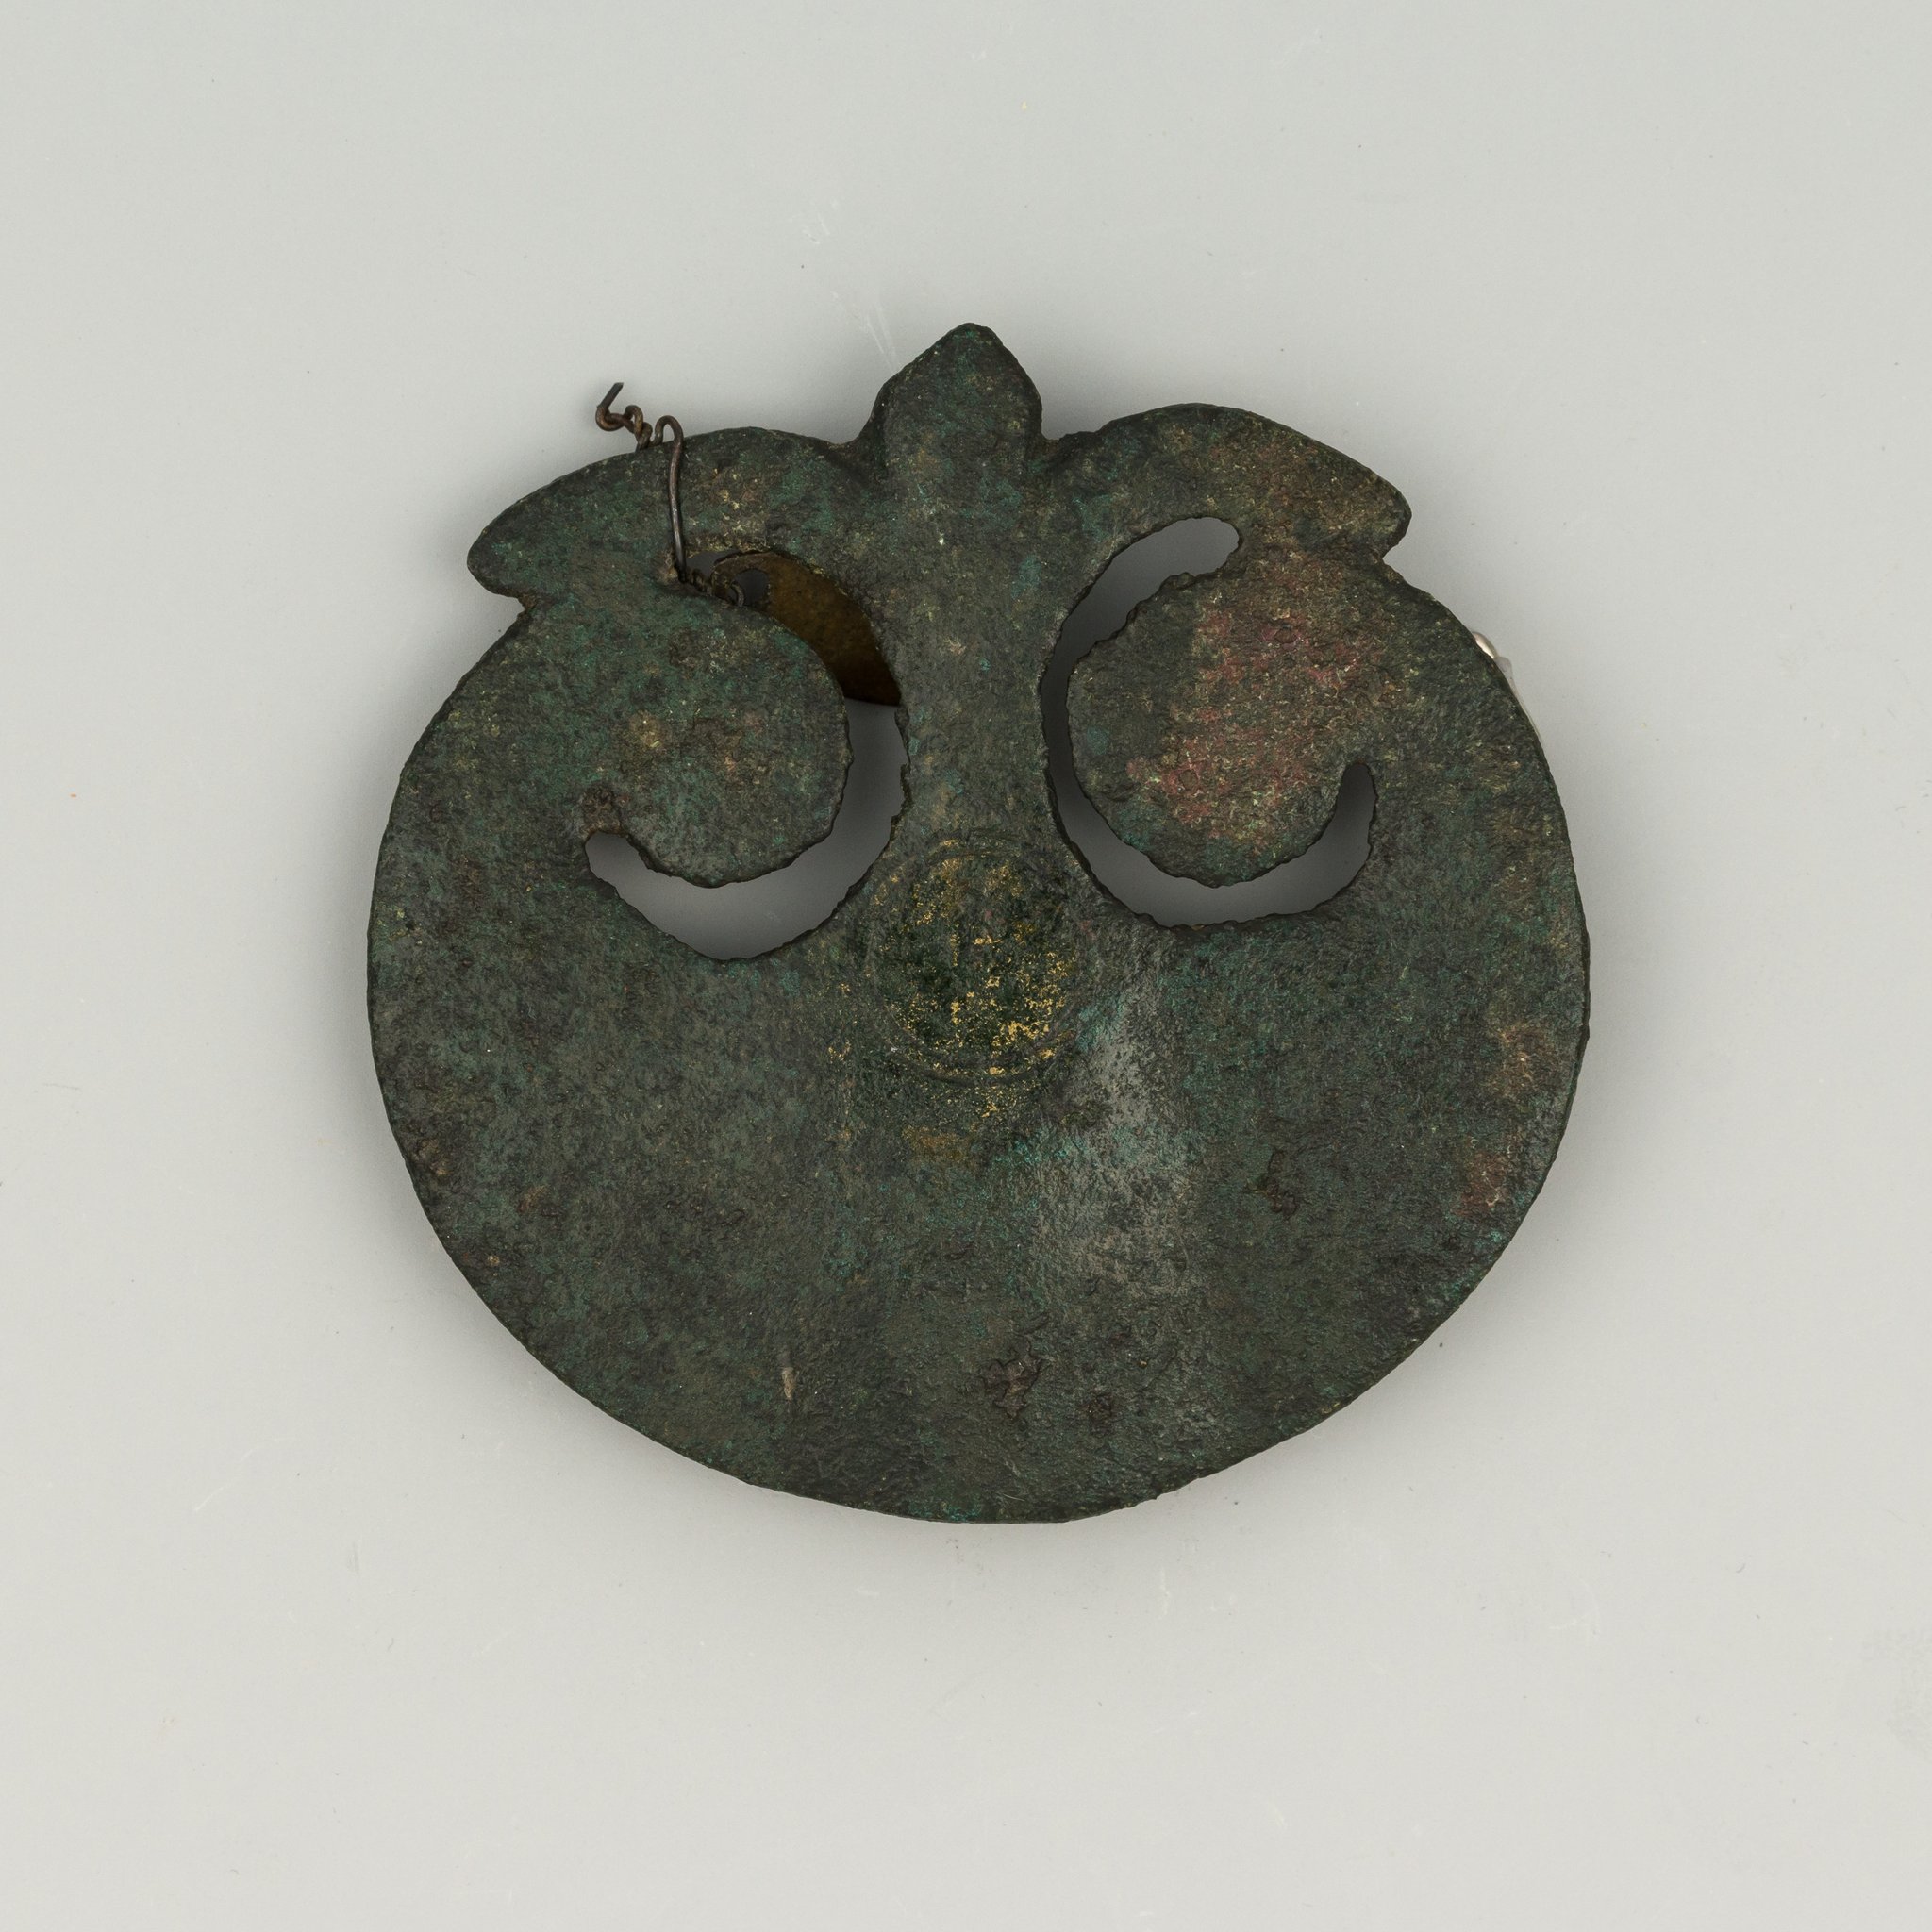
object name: horse tack ornament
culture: roman-german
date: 101-300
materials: copper alloy, gold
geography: germany